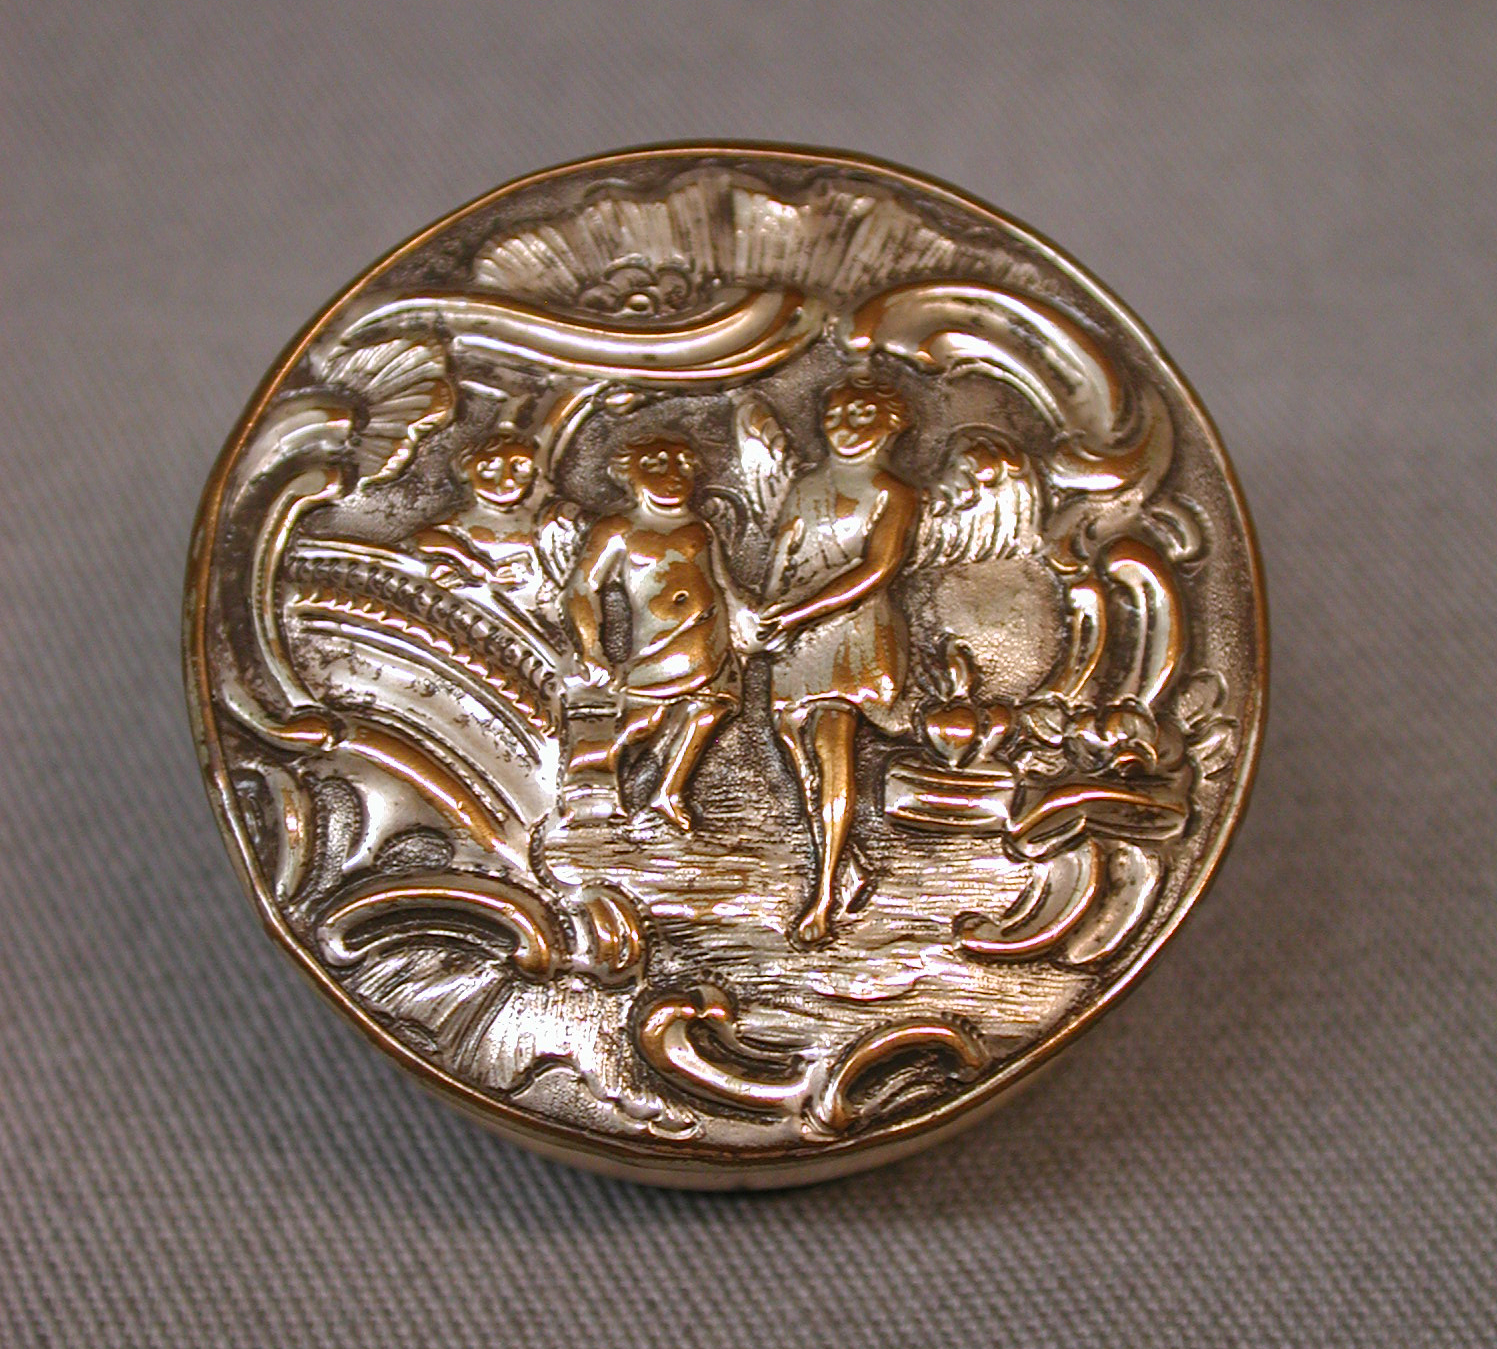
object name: snuffbox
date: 1750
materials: metal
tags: human figures